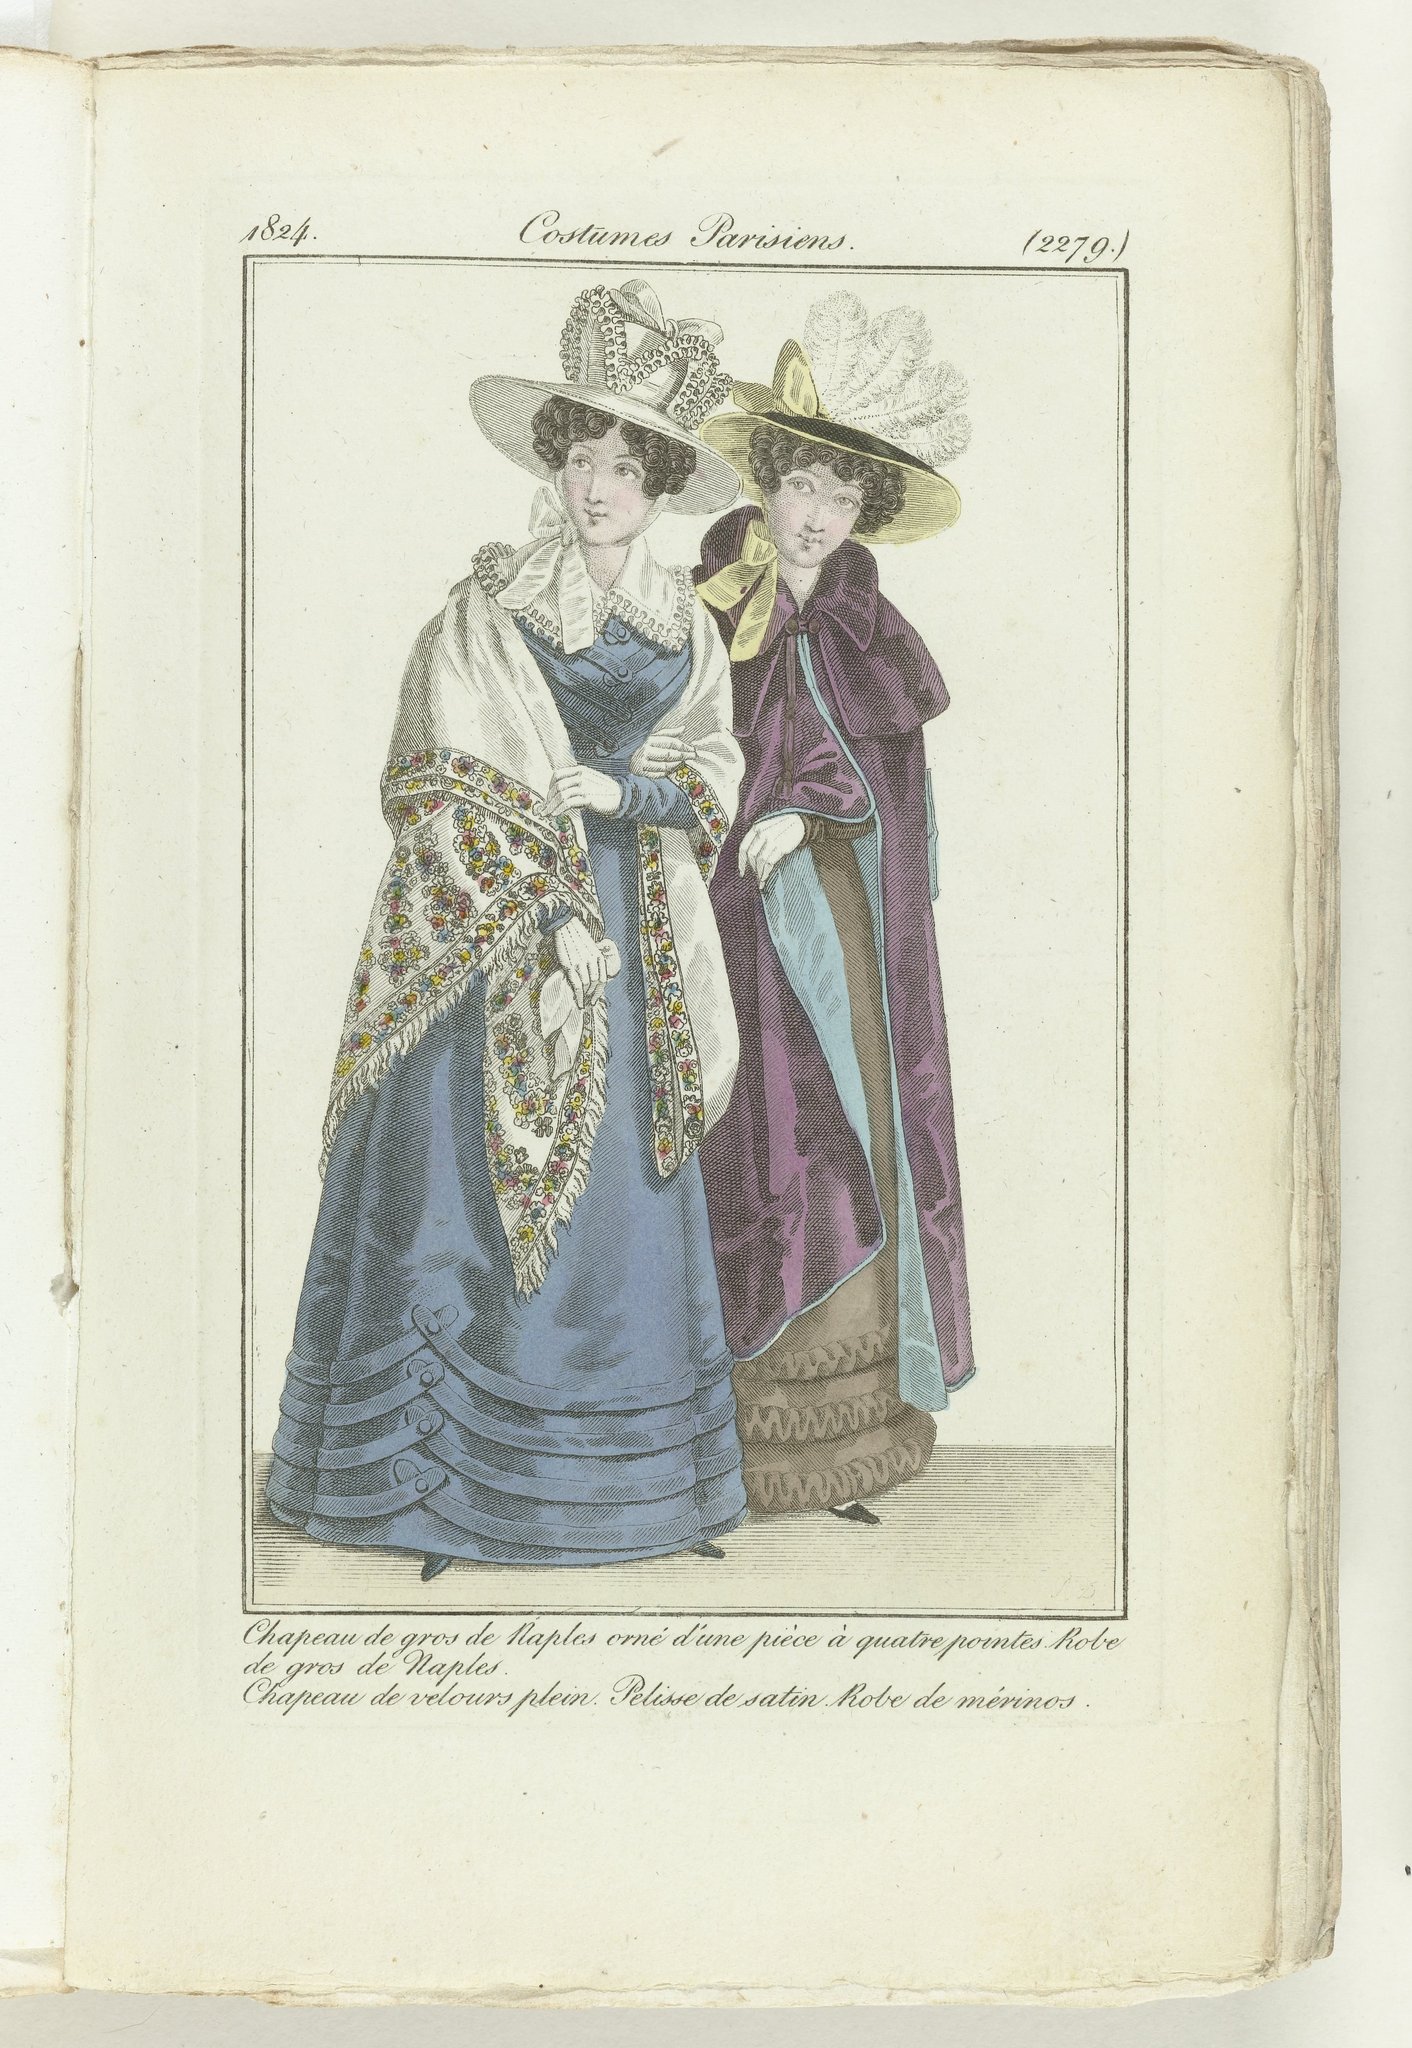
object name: fashion print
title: Journal des Dames et des Modes 1824, Costume Parisien (2279)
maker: Anonymous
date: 1824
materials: paper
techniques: etching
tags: fashion plates, clothes, costume (+ women's clothes)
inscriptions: date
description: Prent uit het tijdschrift Journal des Dames et des Modes, 1824.